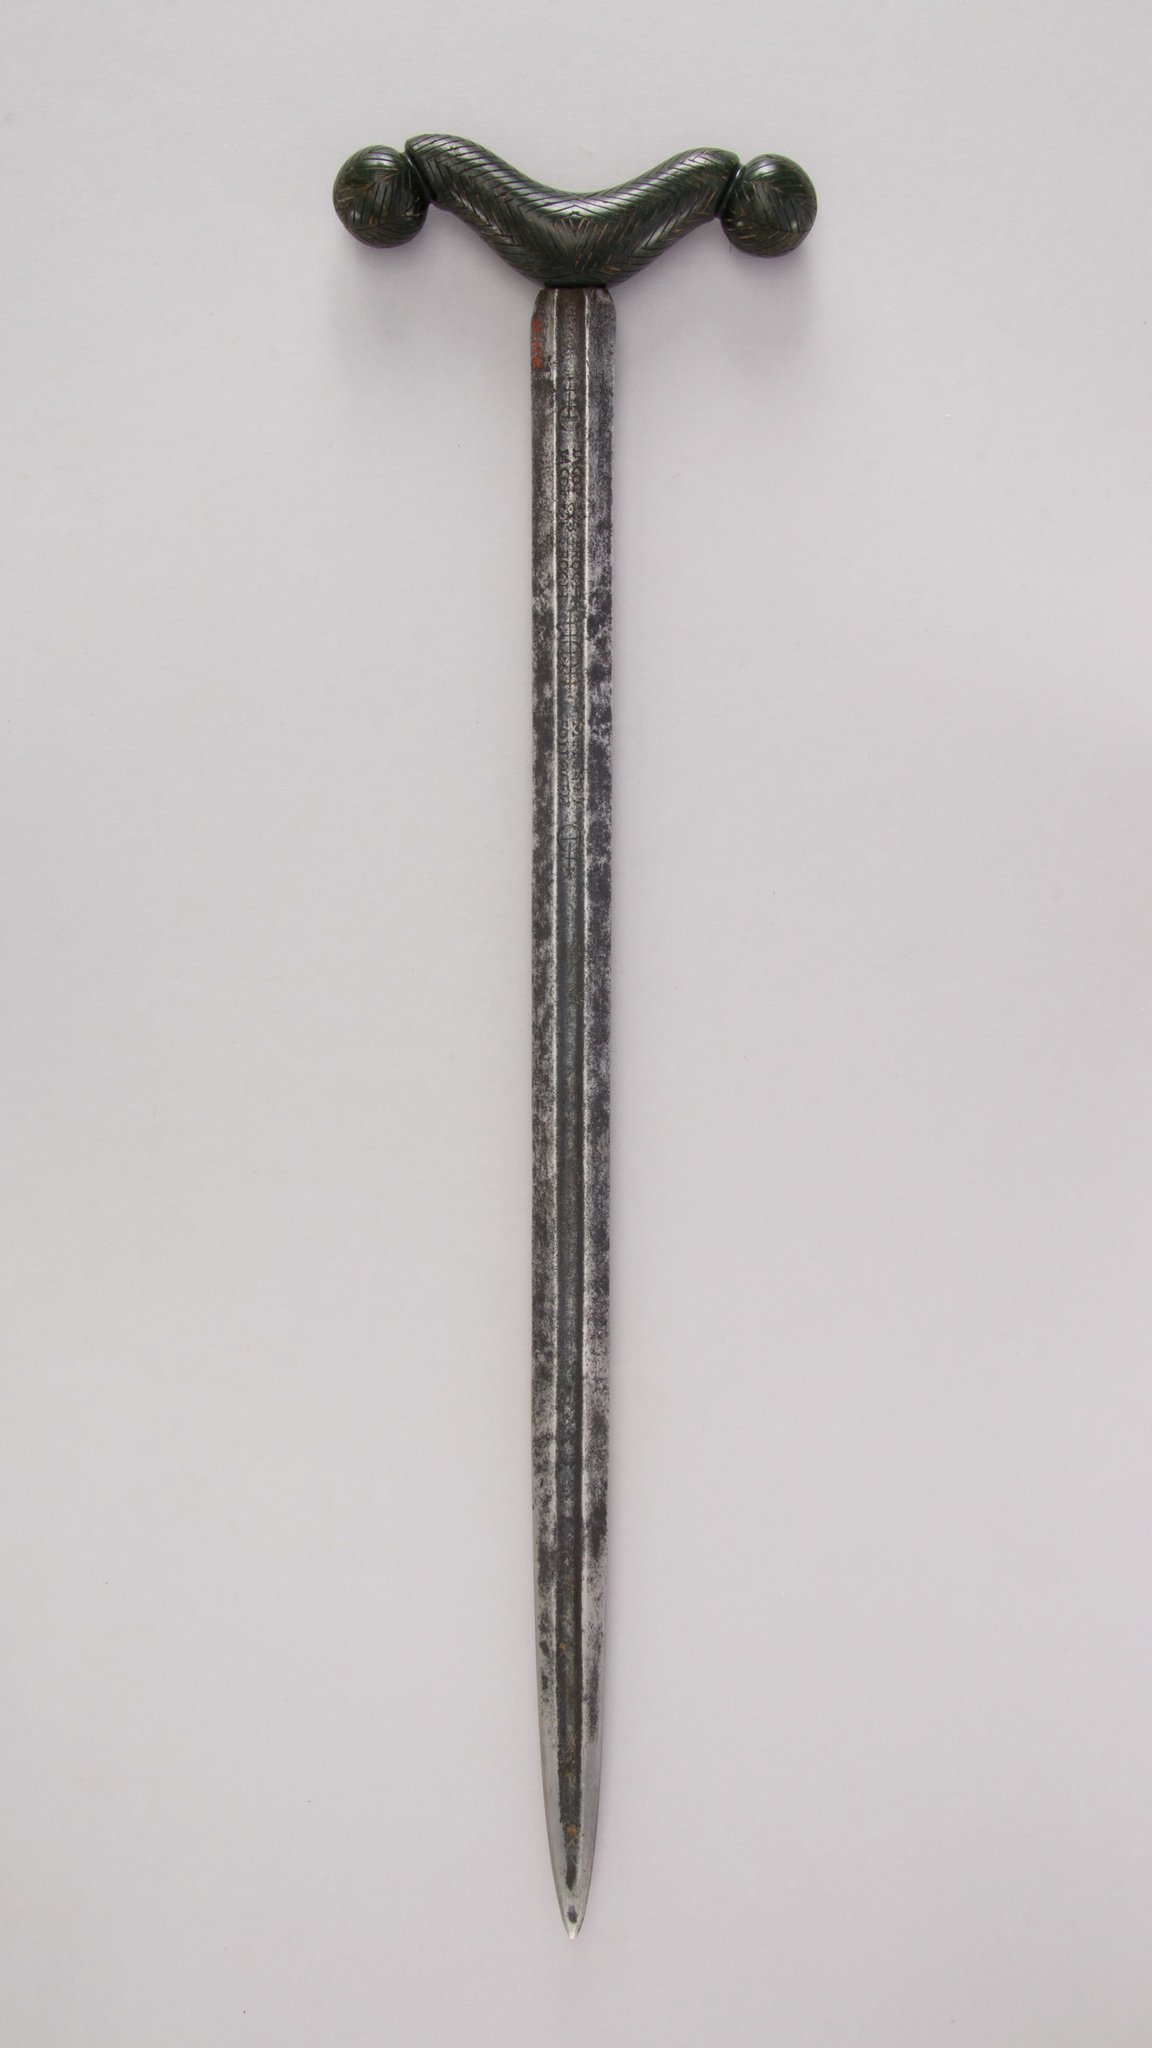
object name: crutch dagger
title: Crutch Dagger (Zafar Takieh, "Cushion of Victory")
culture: indian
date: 1701-1800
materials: jade, steel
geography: germany